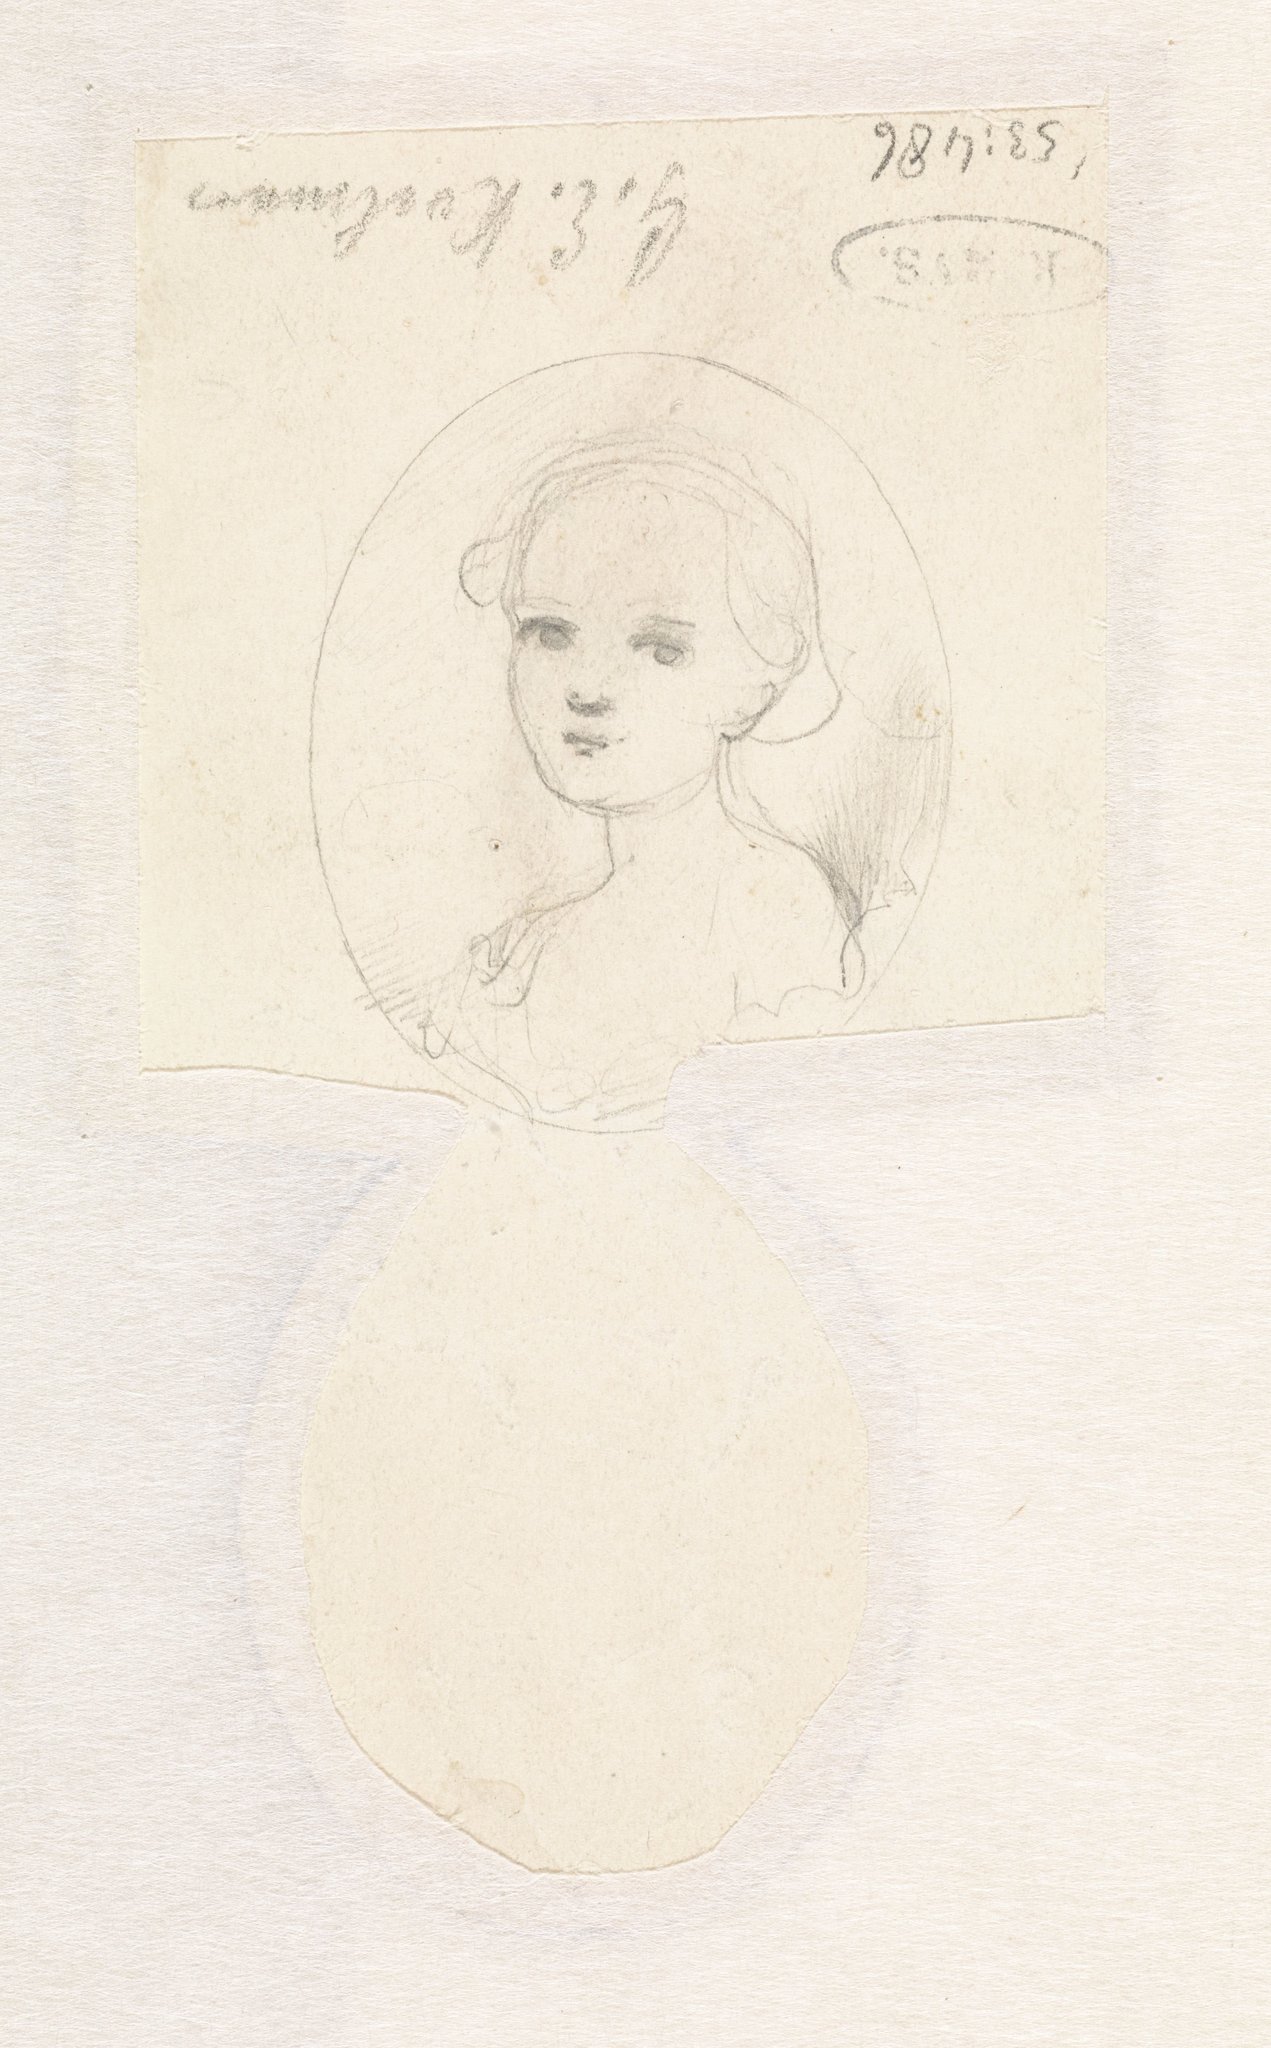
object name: drawing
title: Portret van een kind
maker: johan hendrik koelman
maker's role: draughtsman, print maker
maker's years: 1820-1887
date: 1846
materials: paper, pencil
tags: anonymous historical person portrayed alone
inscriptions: date